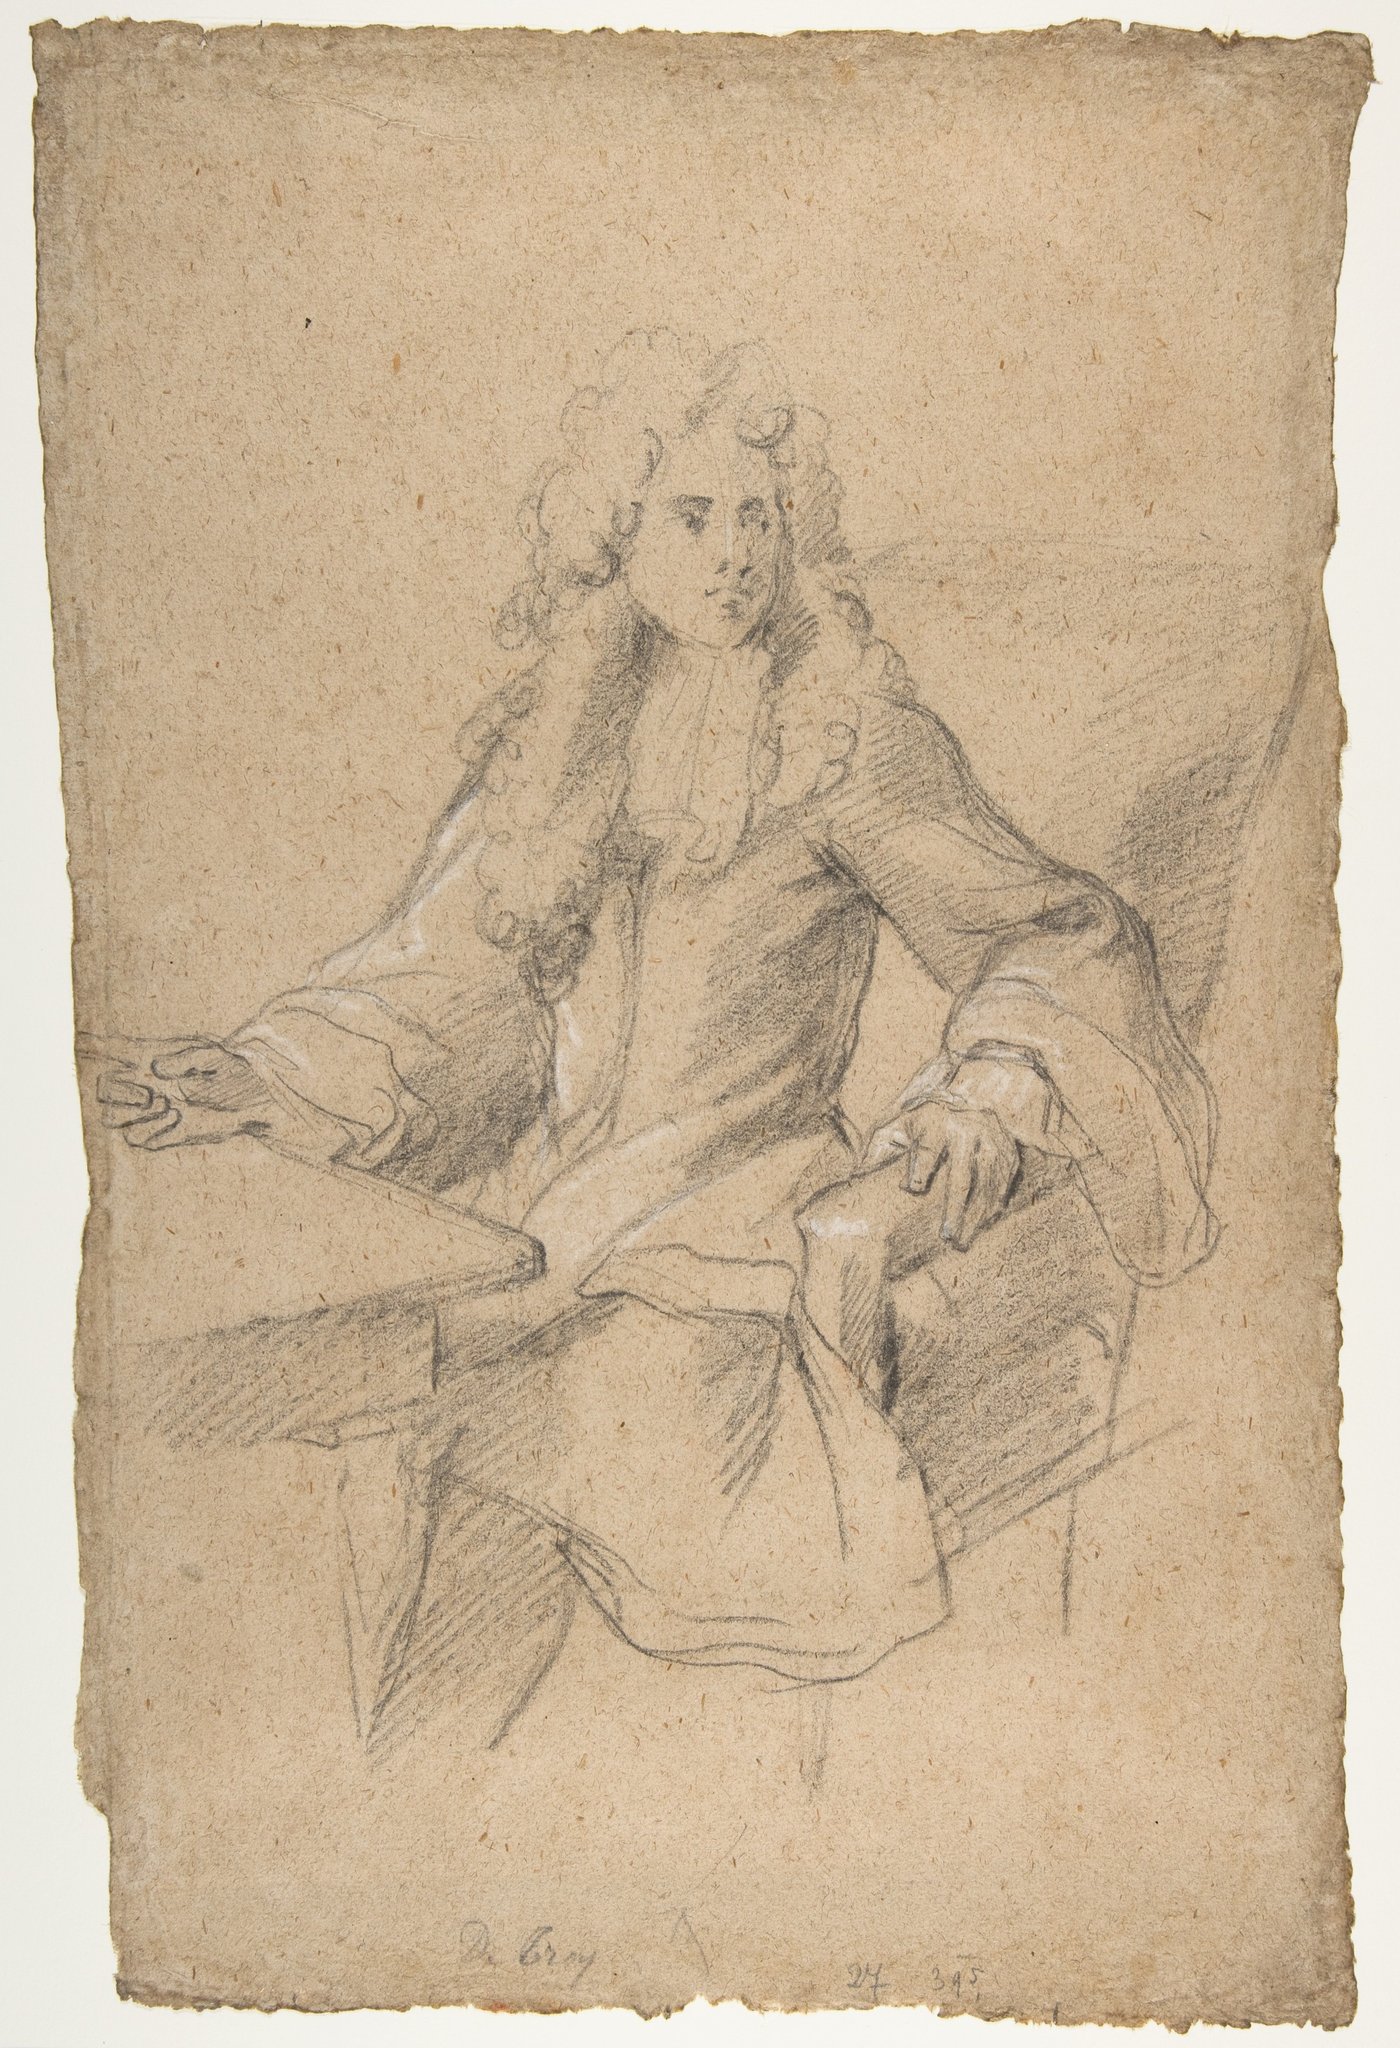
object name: drawing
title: Gentleman Seated at a Table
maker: françois de troy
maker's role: artist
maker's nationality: french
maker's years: 1645-1730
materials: chalk, paper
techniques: heightening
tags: men,portraits,chairs,tables